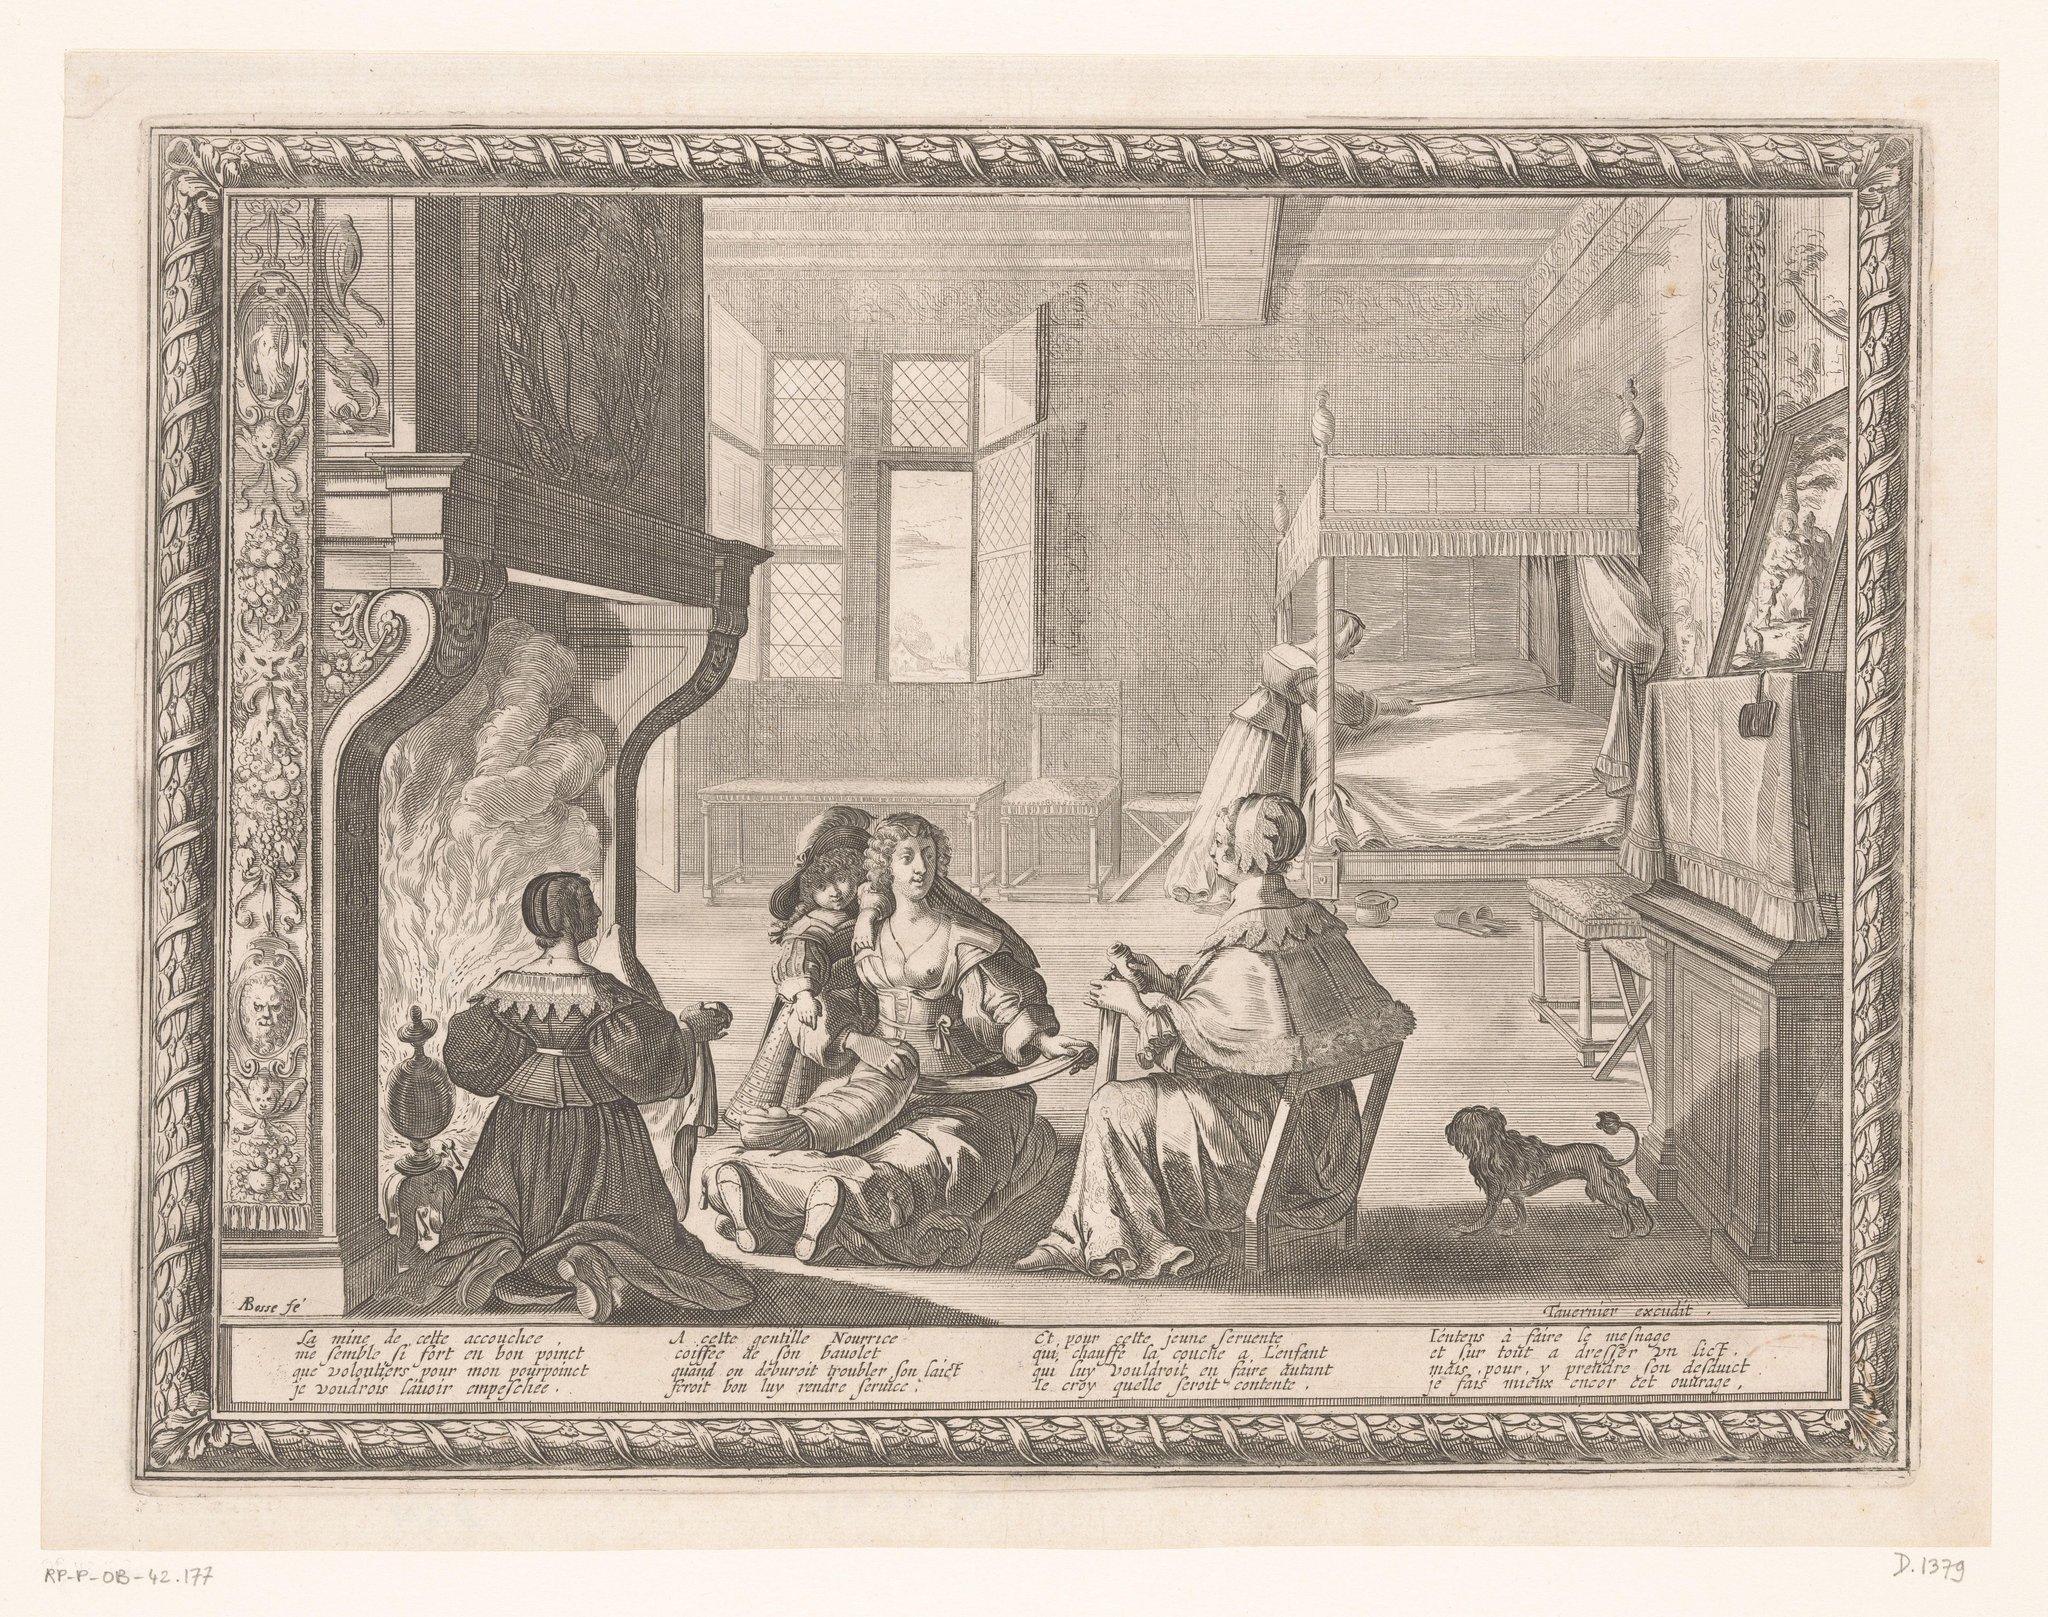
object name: print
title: Le Mariage à la ville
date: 1633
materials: paper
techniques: engraving, etching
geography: paris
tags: open hearth, fire-place, bed, infant, baby, wet-nurse, bedroom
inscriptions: collector's mark: Lugt 240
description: Maakt deel uit van een serie van zes prenten over het huwelijk.